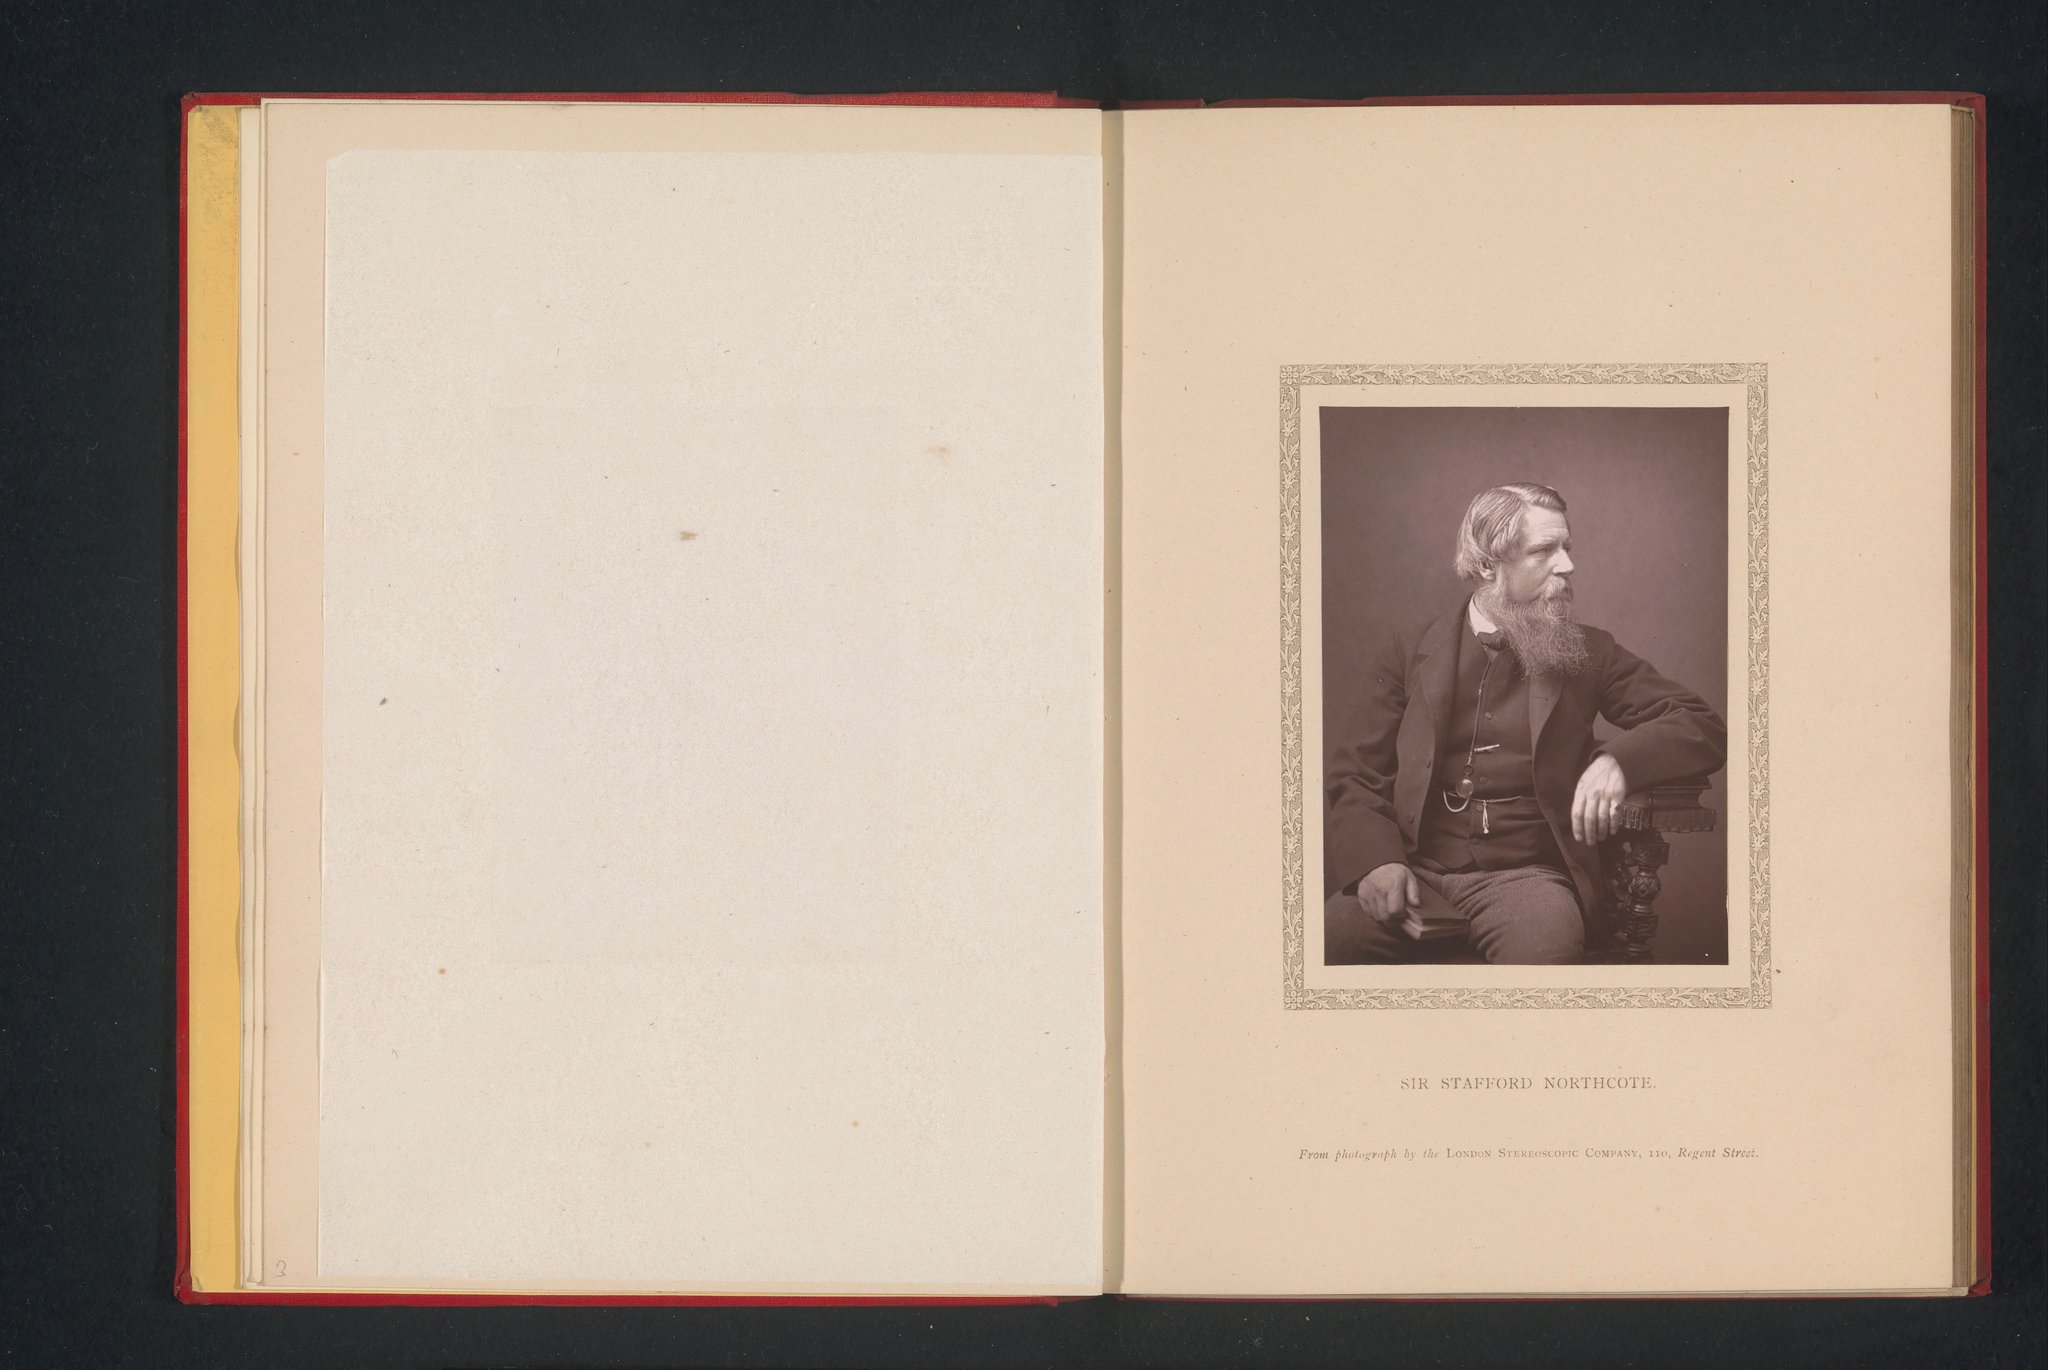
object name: photomechanical print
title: Sir Stafford Northcote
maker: Anonymous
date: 1876-1881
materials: paper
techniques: woodburytype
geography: london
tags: politician, politician, e.g. party leader